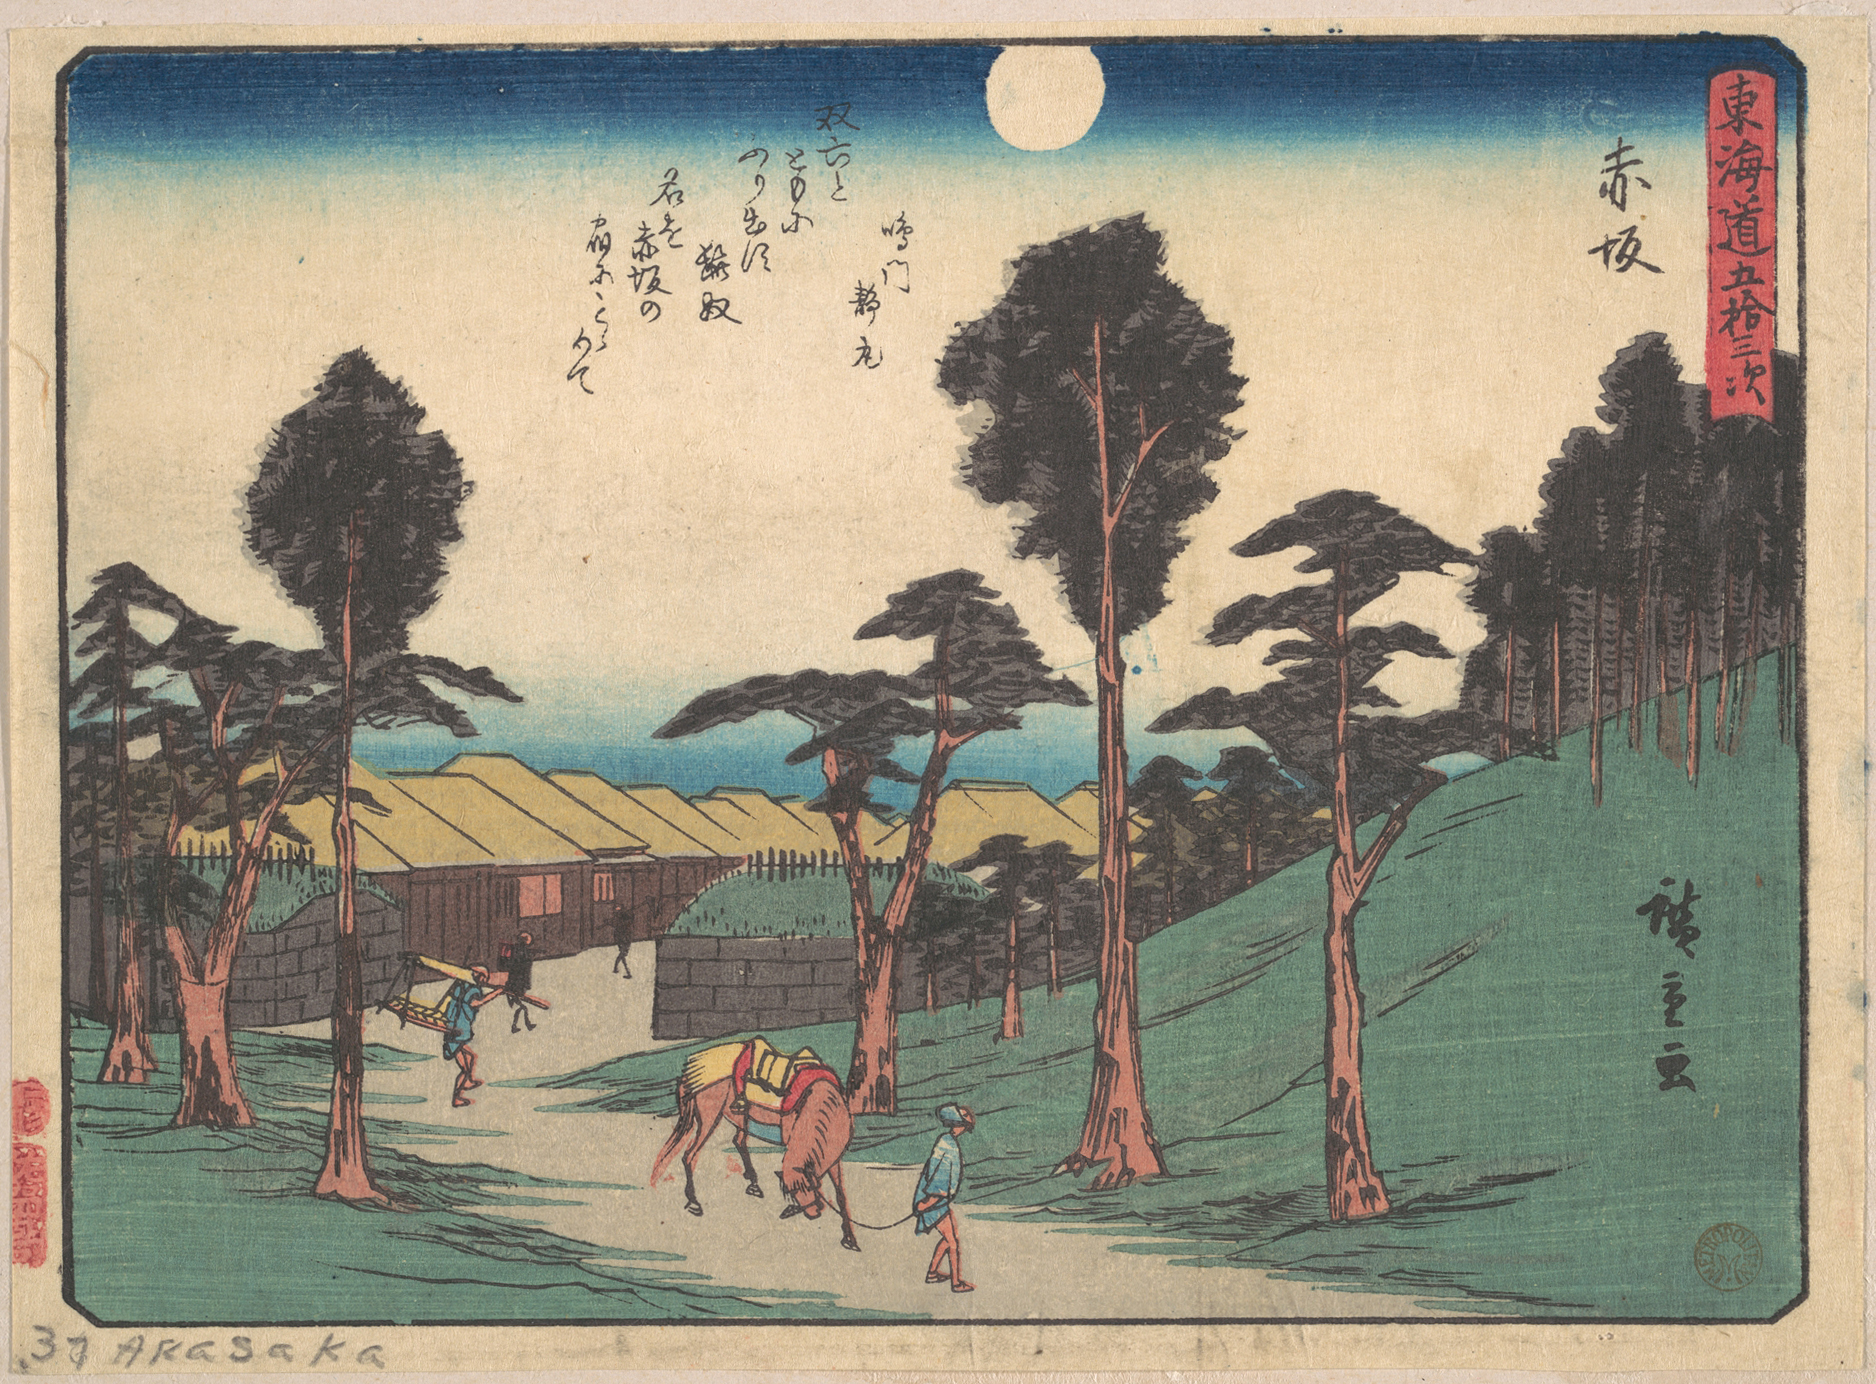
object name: print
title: Akasaka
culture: japanese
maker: utagawa hiroshige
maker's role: artist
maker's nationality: japanese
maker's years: 1797-1858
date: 1838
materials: ink, paper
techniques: woodblock print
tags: human figures,houses,horses,moon,trees